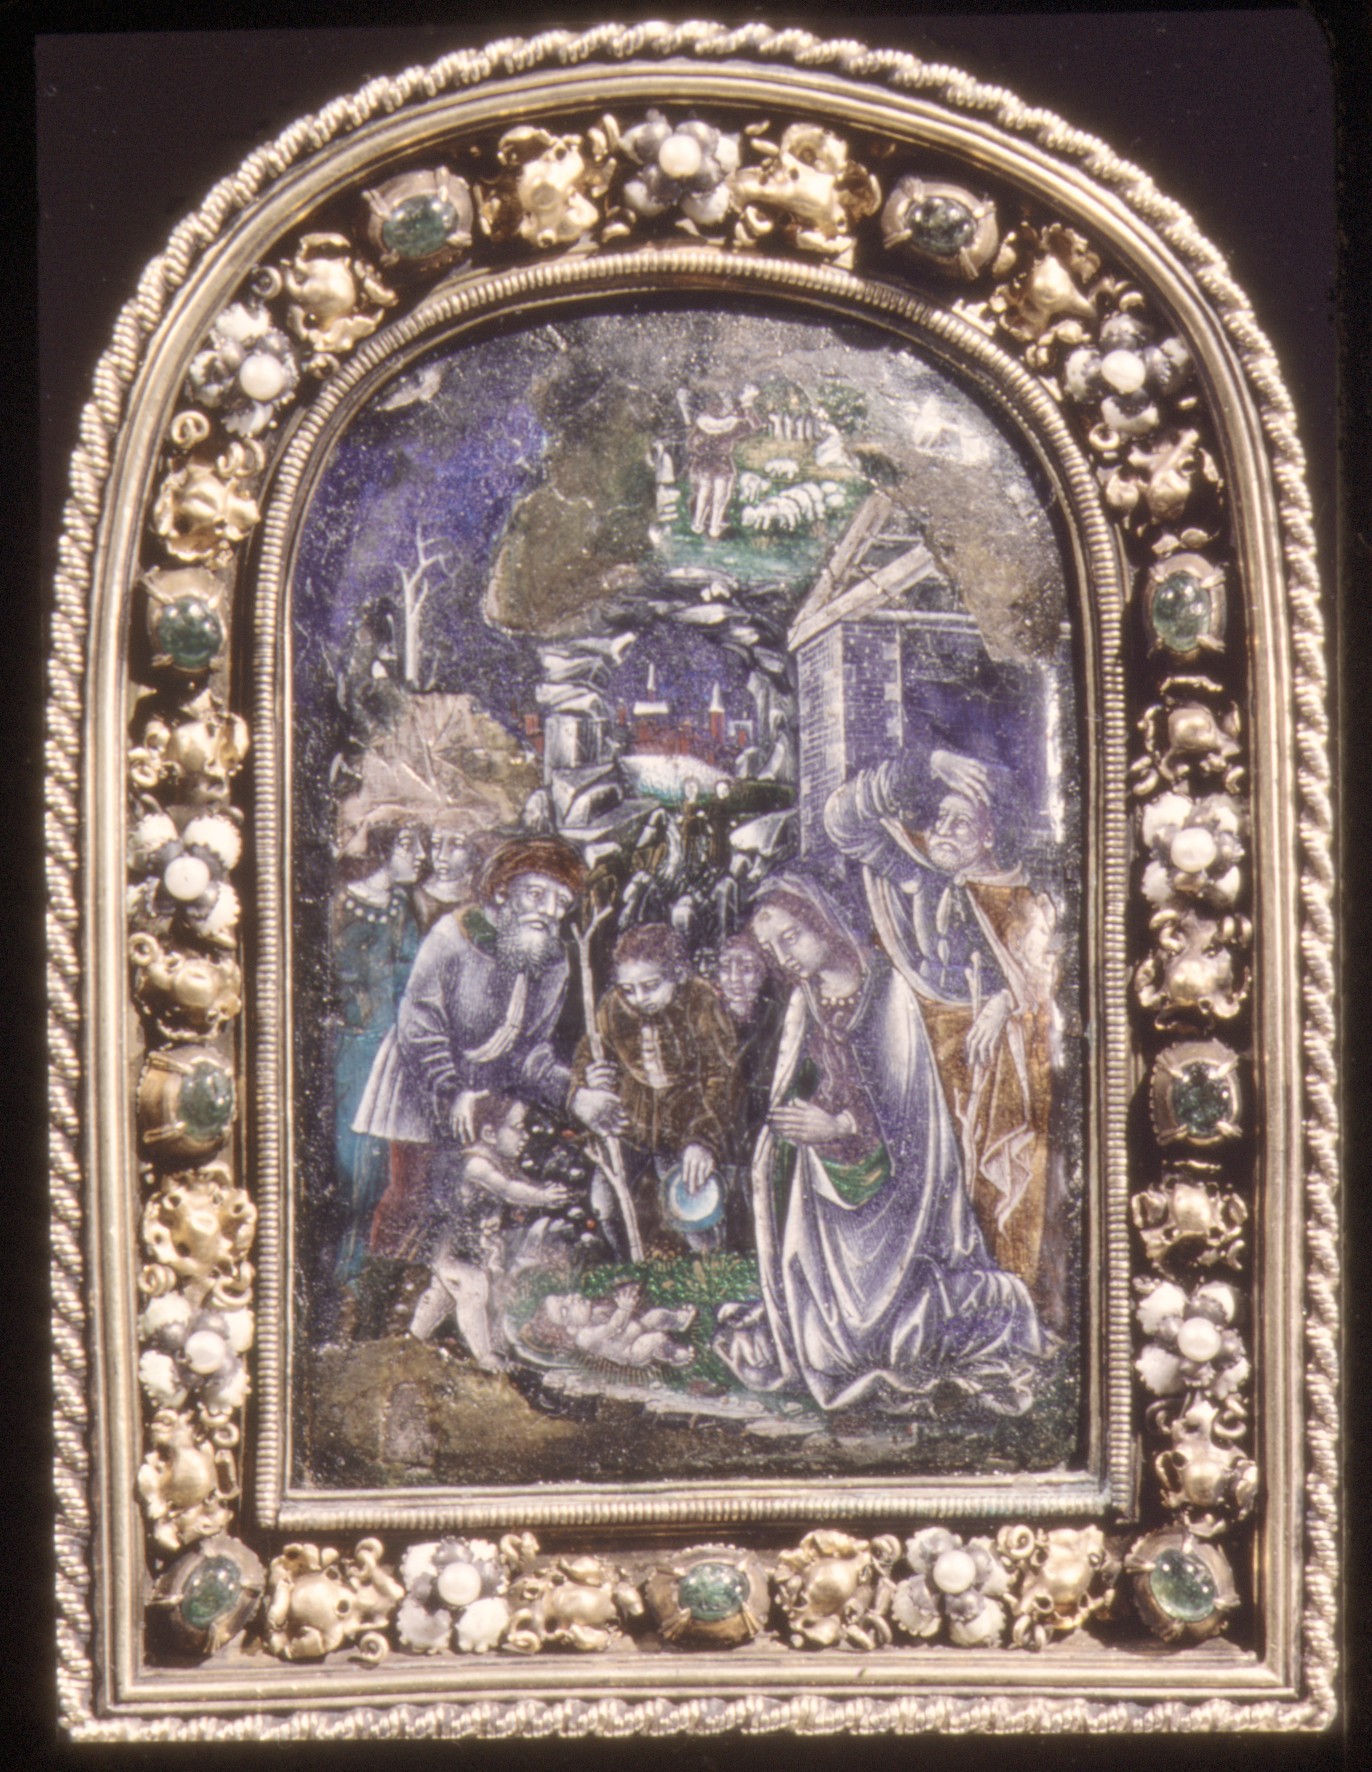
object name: pax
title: Adoration of the Shepherds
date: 1467-1500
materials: gemstone, enamel, silver gilt, gold, pearl, silver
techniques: enamel, painting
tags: adoration of the shepherds